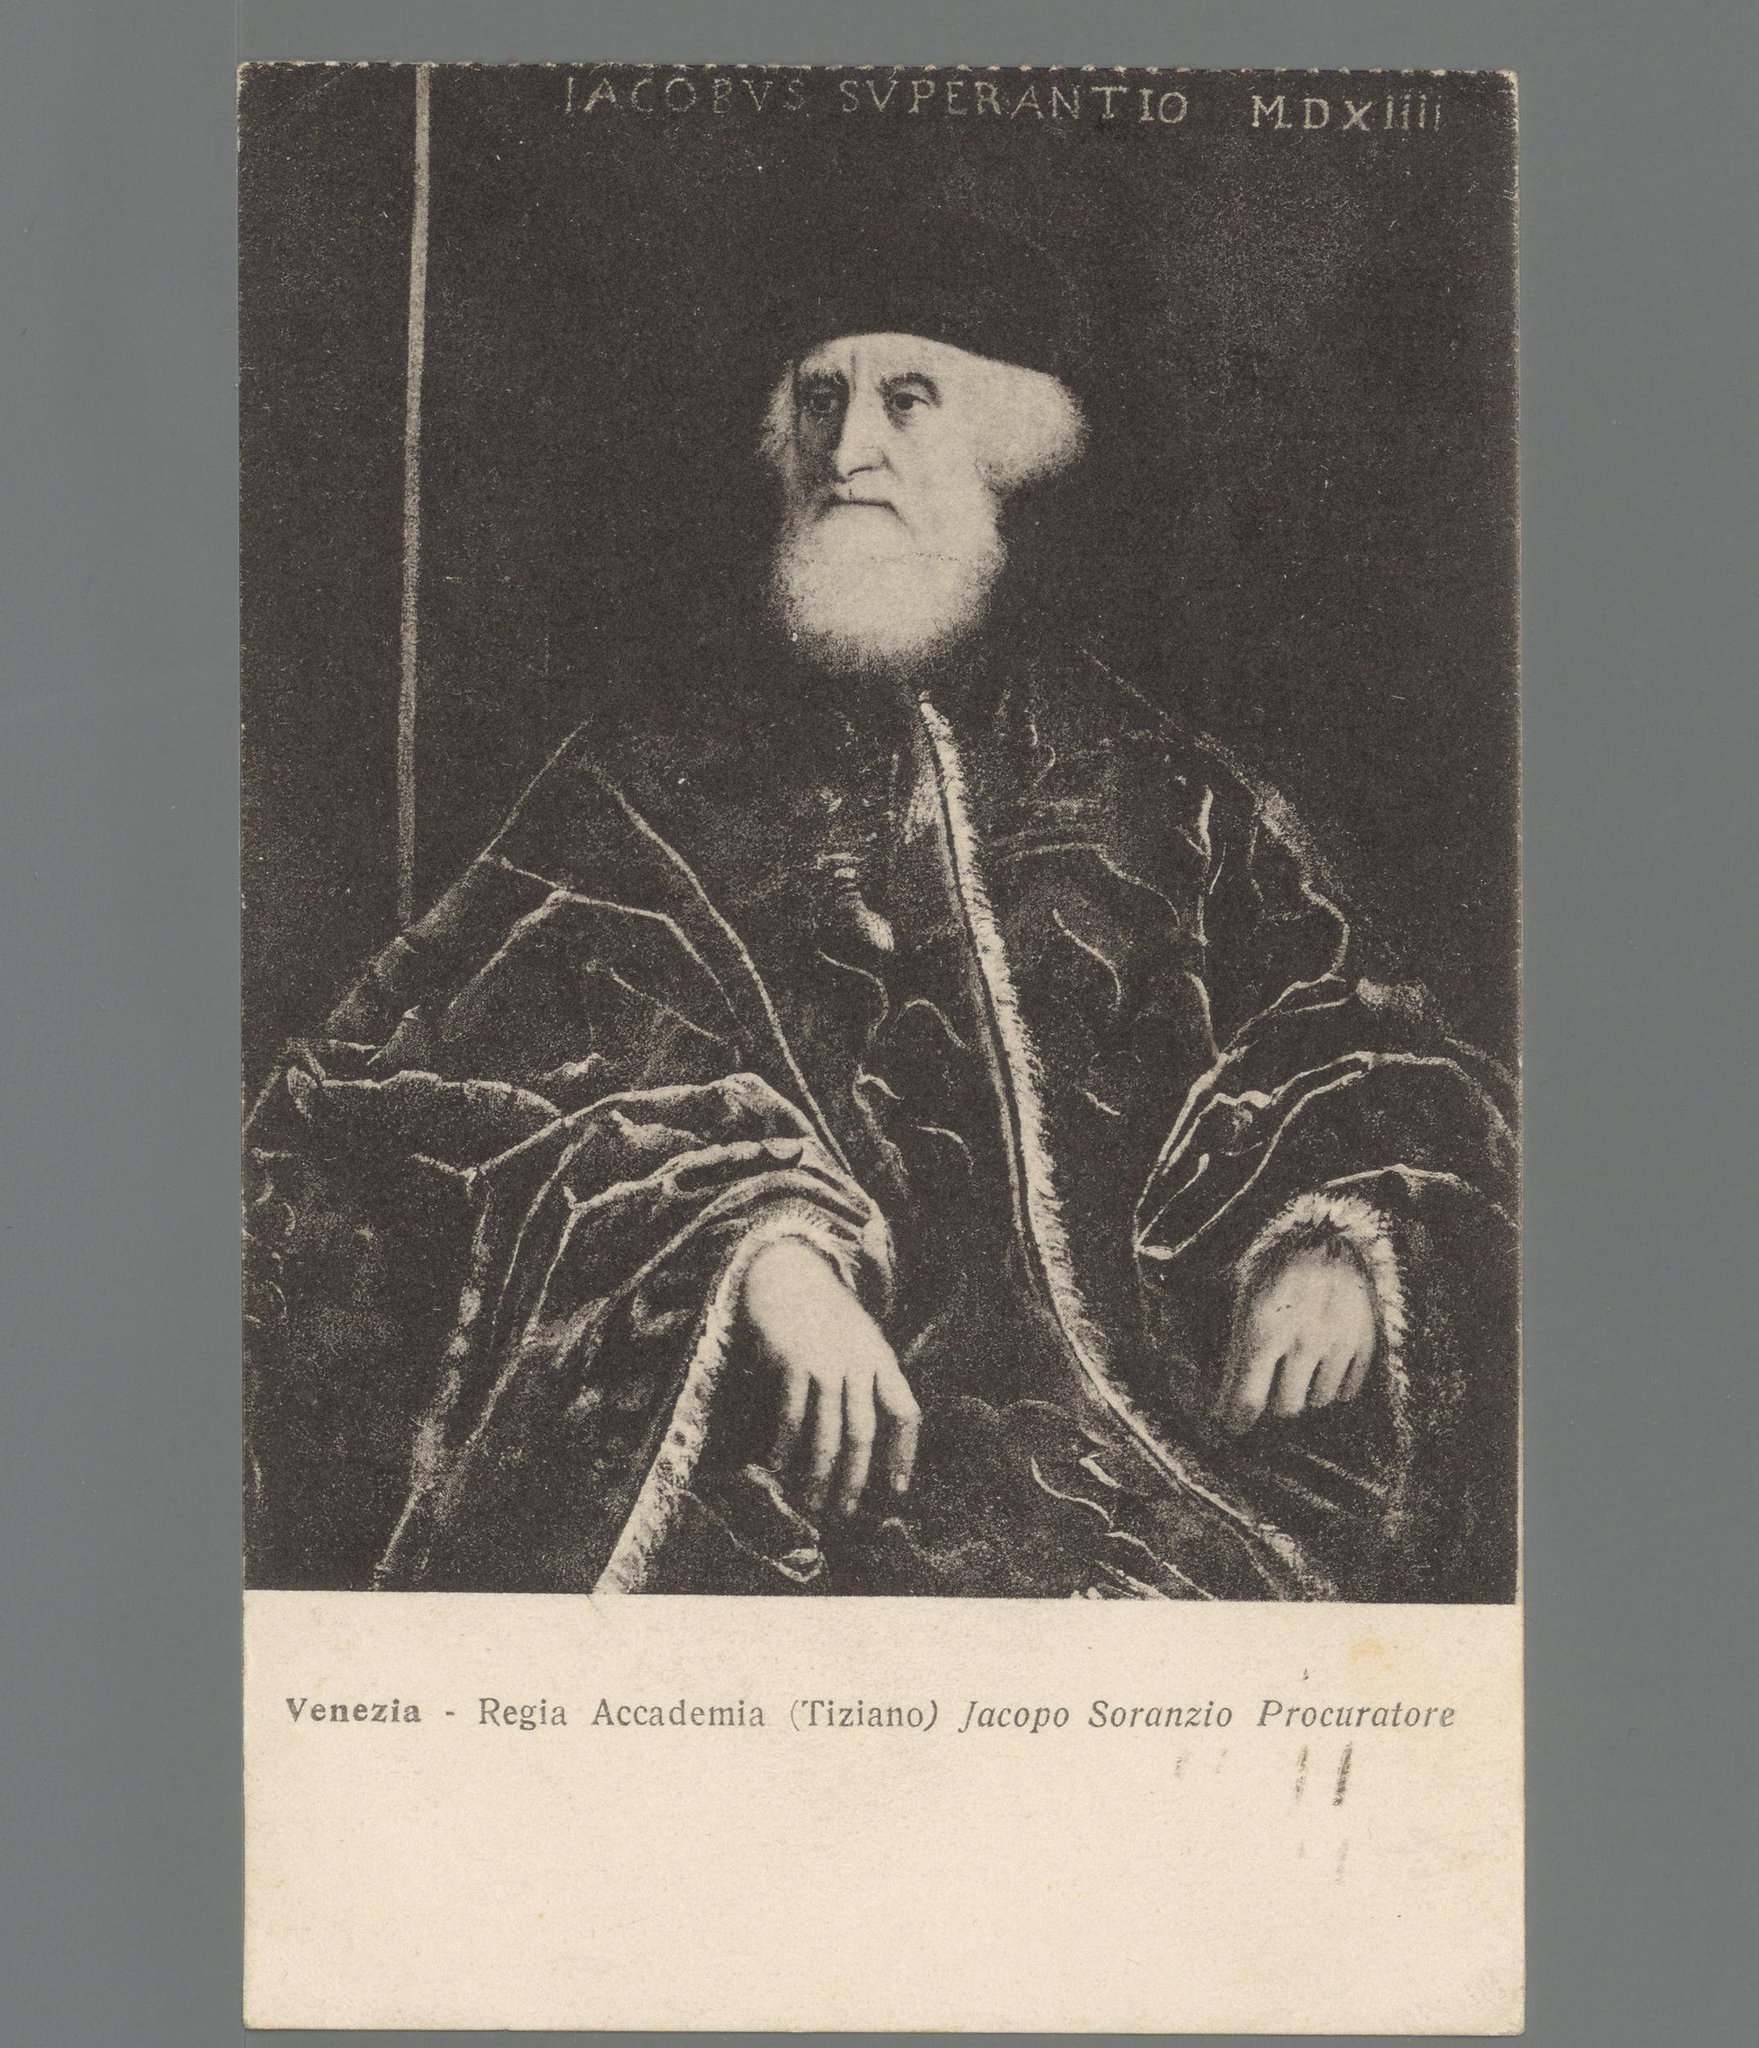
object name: reproduction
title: Venezia - Regia Accademia (Tiziano). Jacopo Soranzio Procuratore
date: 1906-1931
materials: cardboard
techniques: photograph, writing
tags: permanent exhibition, museum, picture, painting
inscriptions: postage stamp, collector's mark: ‘AFE v S’